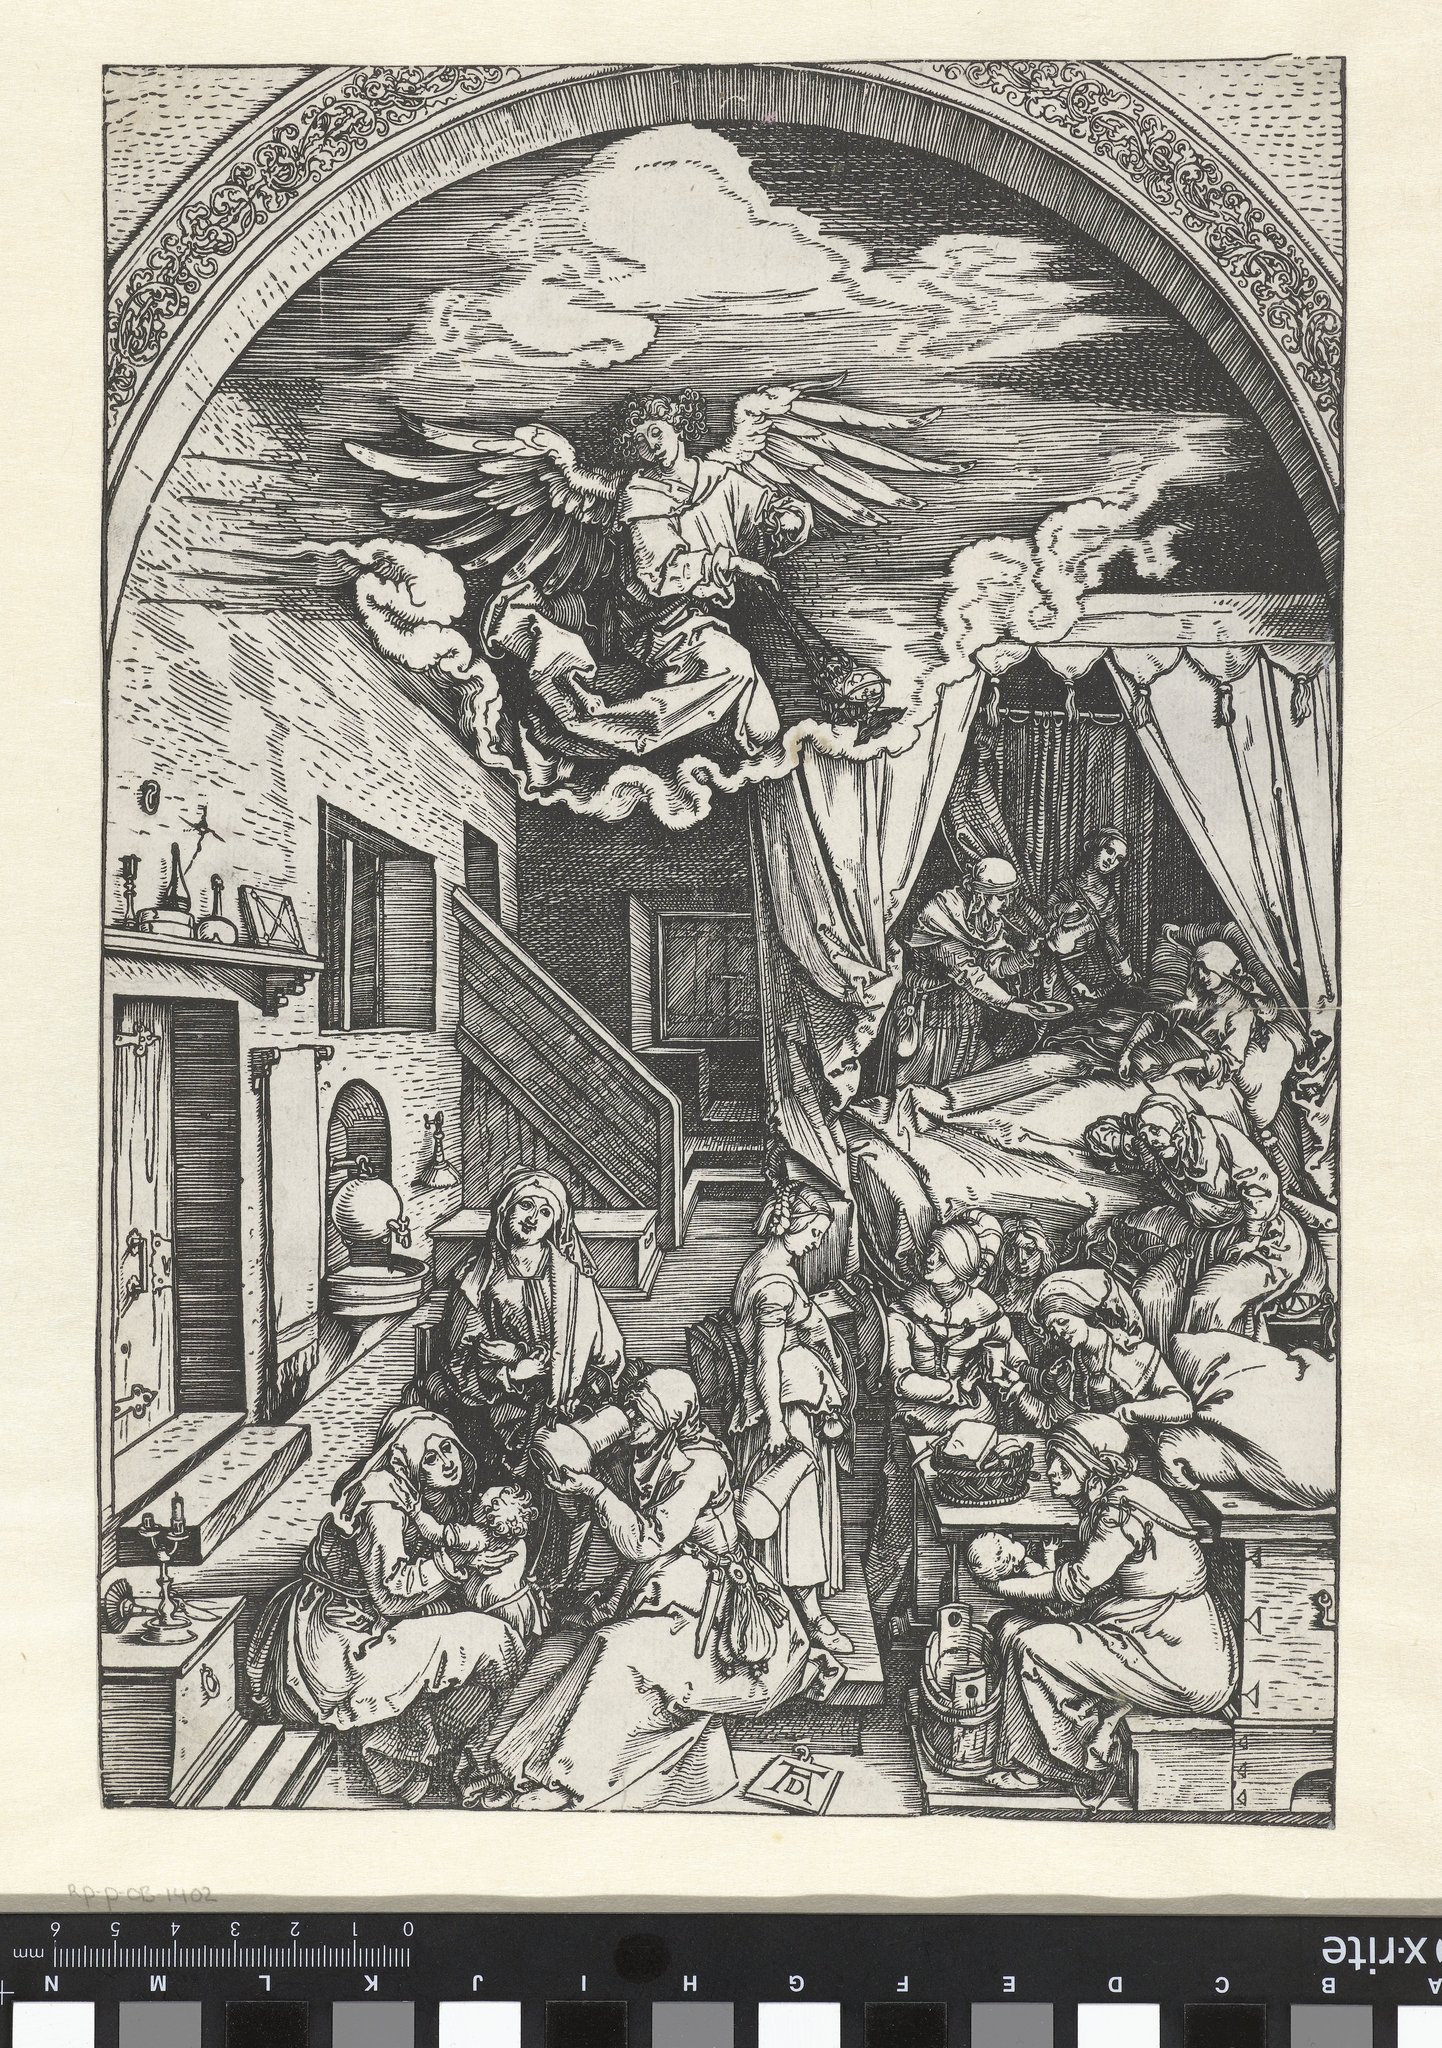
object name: print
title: De geboorte van Maria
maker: albrecht dürer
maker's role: draughtsman, painter, print maker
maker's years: 1471-1528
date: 1501-1505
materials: paper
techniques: woodcut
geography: nuremberg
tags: birth of mary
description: Rechts op de achtergrond in een groot vertrek ligt Anna in een bed nadat zij Maria gebaard heeft. Op de voorgrond is een groep vrouwen bezig met drinken, praten, het verzorgen van de pasgeborene. Een engel bewierookt het tafereel vanuit de lucht. Deze prent is onderdeel van een serie van 20 prenten, bestaand uit een titelprent en 19 prenten met scènes uit het leven van Maria.